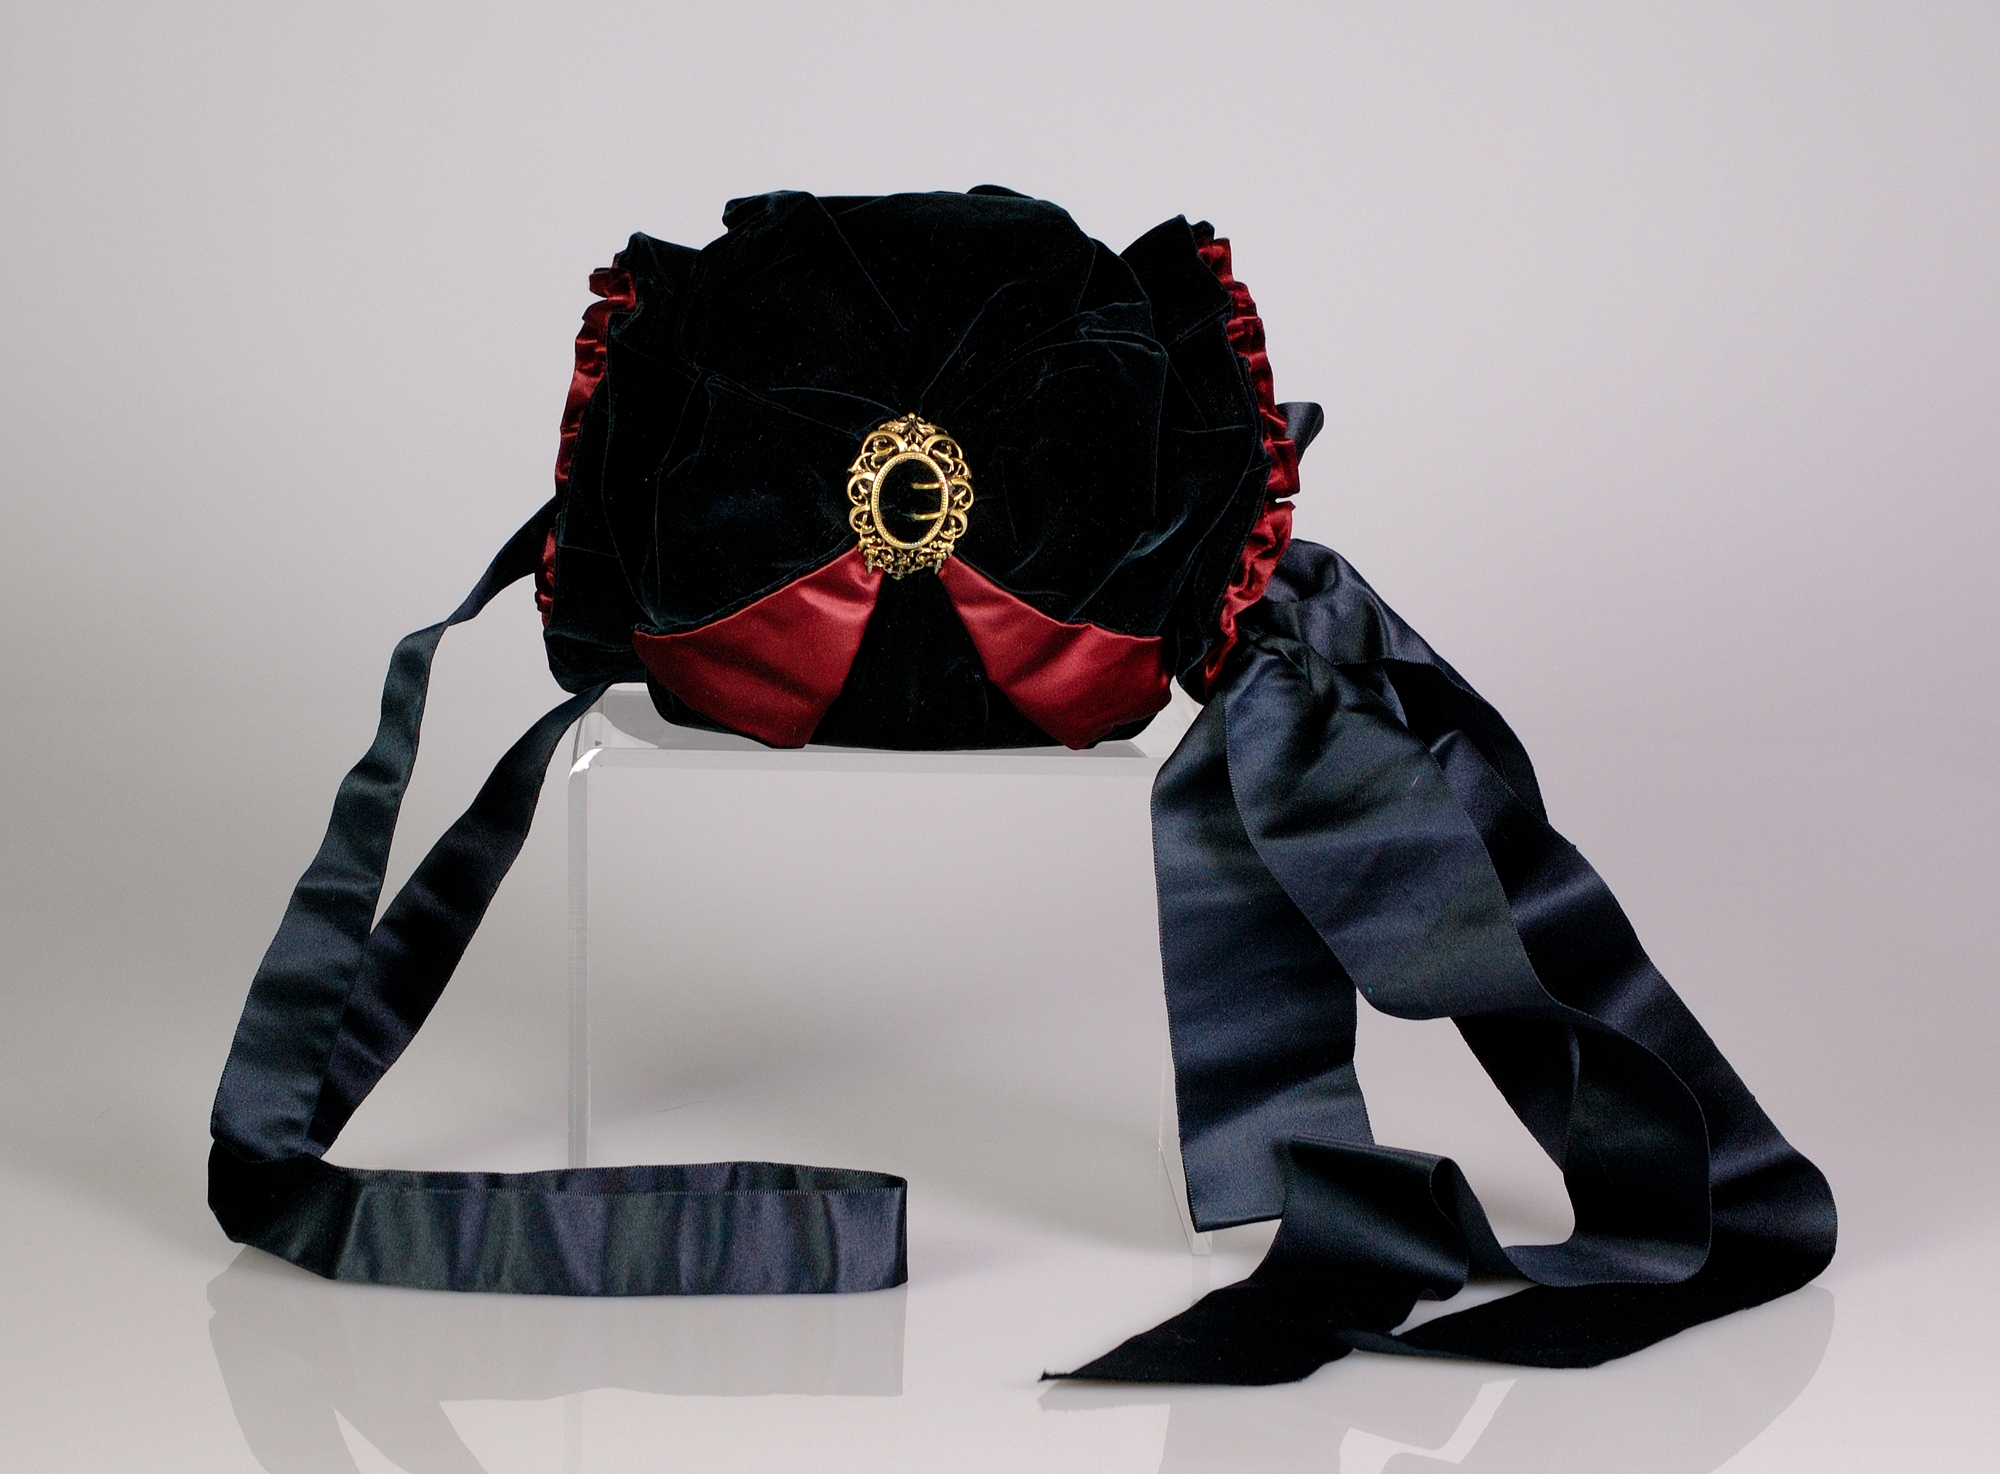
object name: evening muff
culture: american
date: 1880-1889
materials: silk